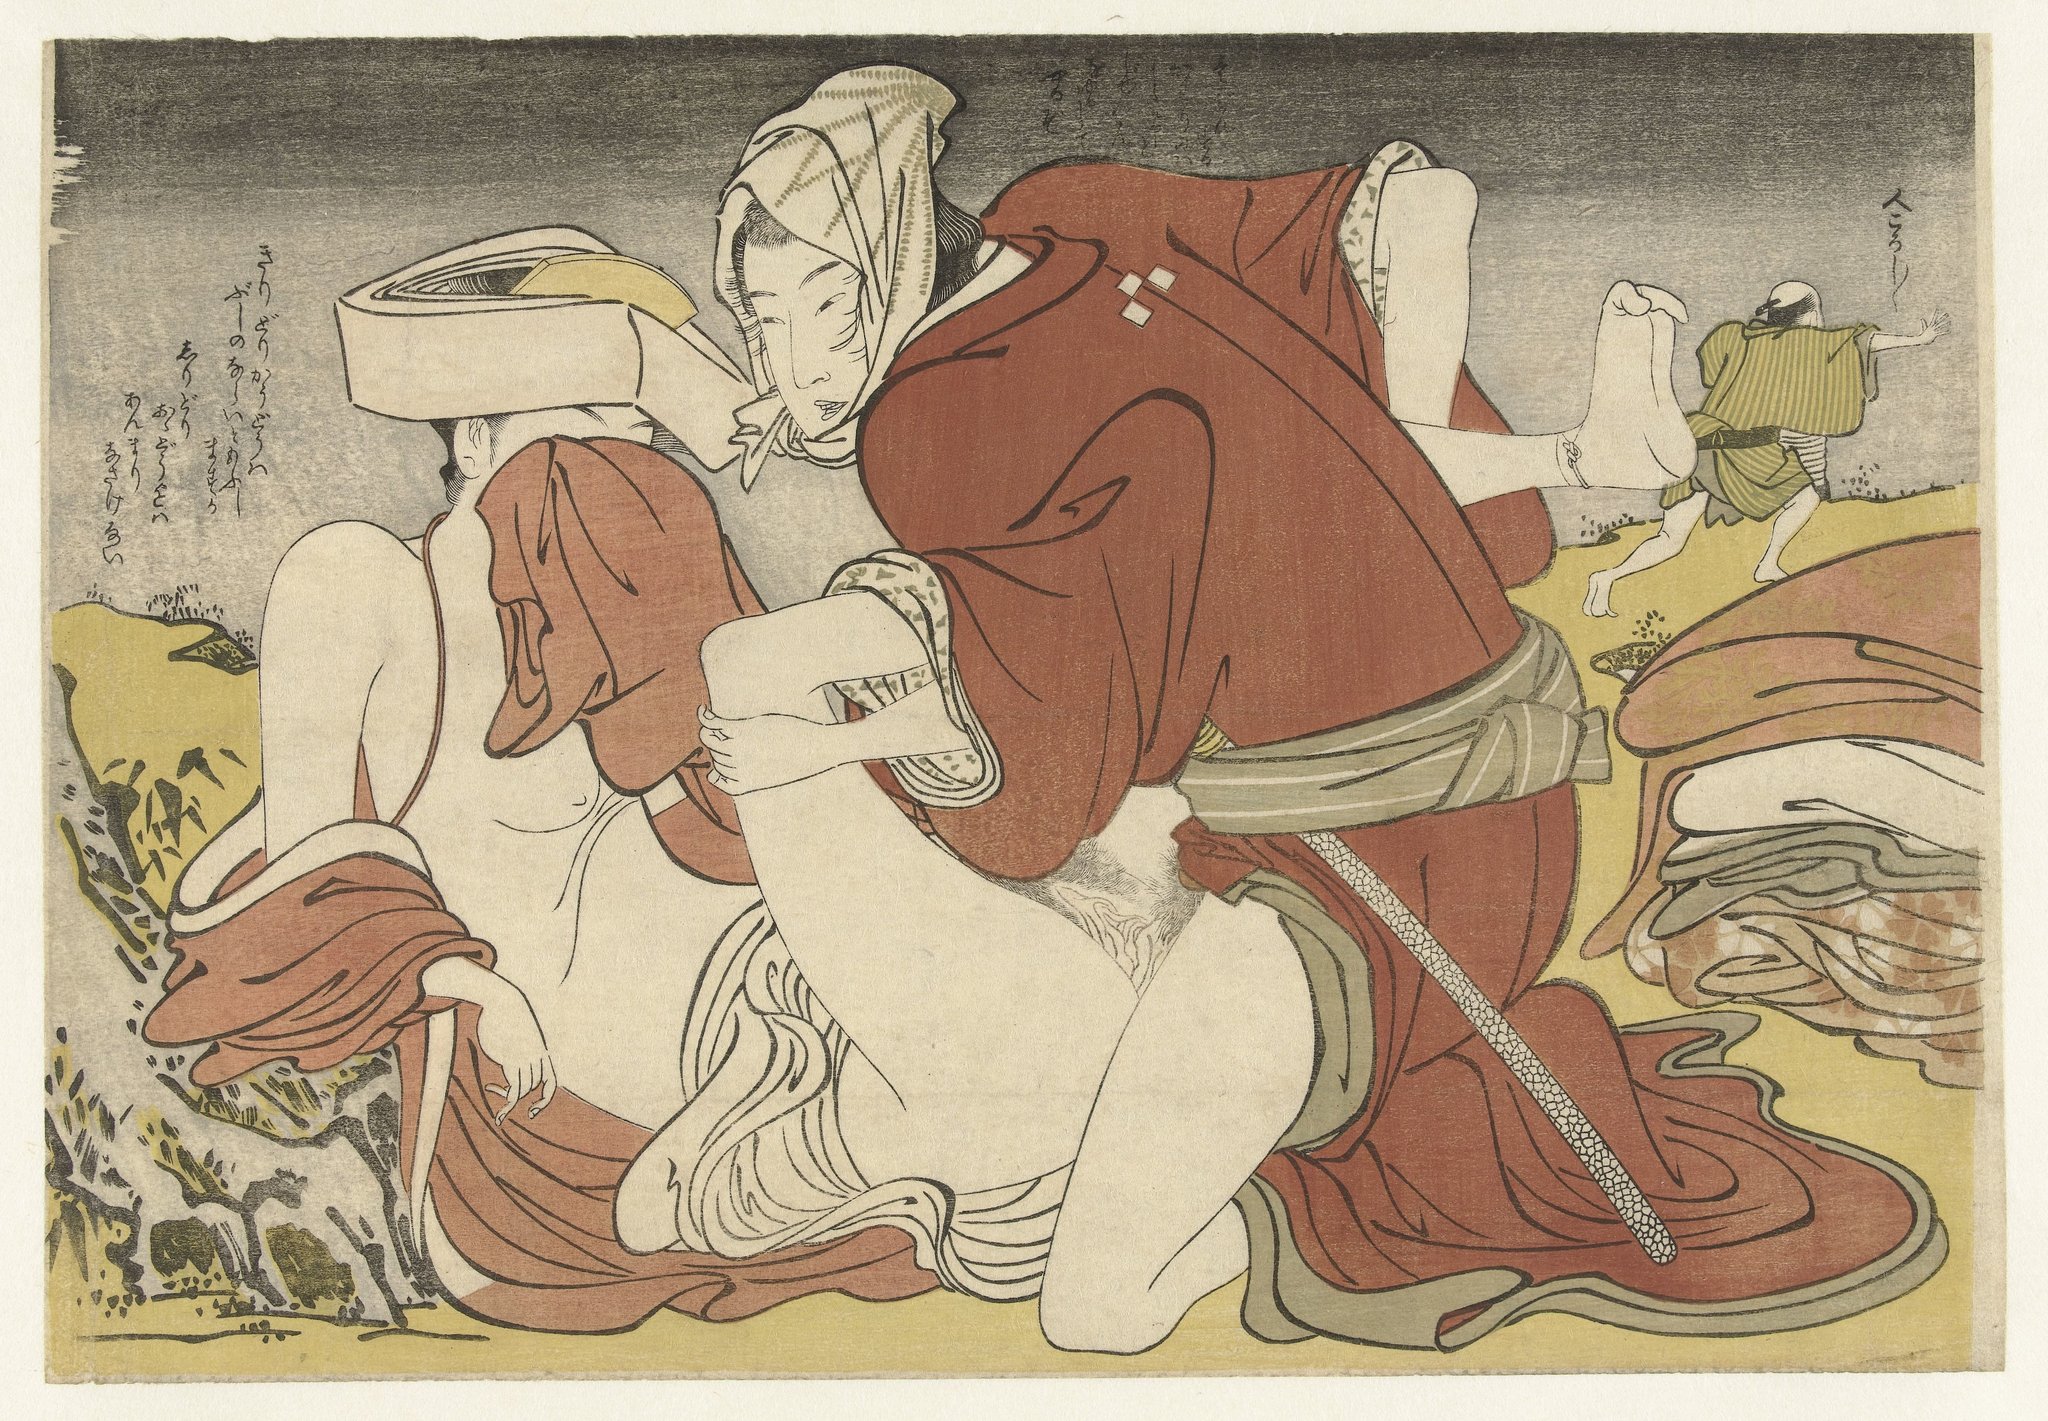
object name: print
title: Rover overmeestert jonge reizigster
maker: katsukawa shunchō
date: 1786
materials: paper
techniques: woodcut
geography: japan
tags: rape, violation, coitus, cohabiting, sexual intercourse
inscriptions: collector's mark: Lugt 2228, collector's mark: Lugt 2760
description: Naakte vrouw, een mouw voor haar gezicht houdend, overmeesterd door een man met doek om hoofd en zwaard langs linker zij. In de achtergrond een wegvluchtende man.